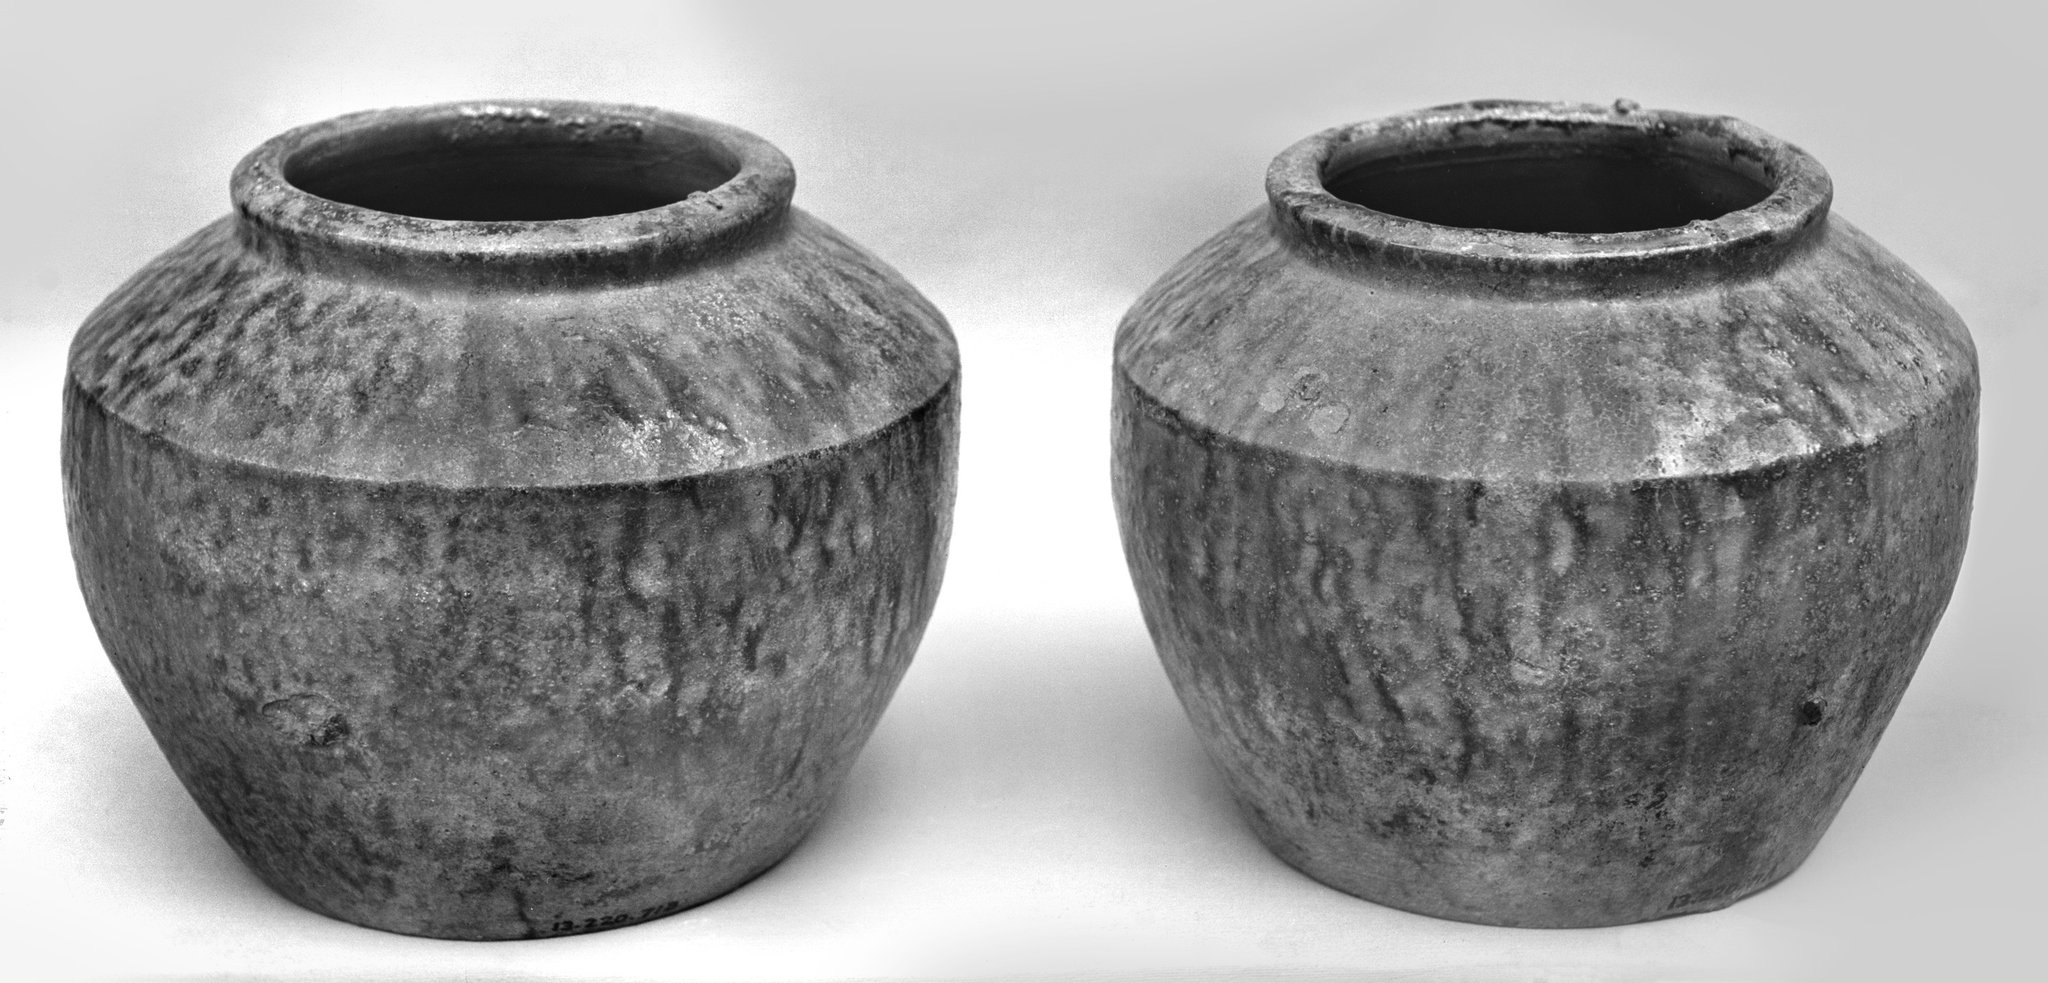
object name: vase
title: Pair of Vases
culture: chinese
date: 206 BCE-220 CE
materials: glaze, pottery